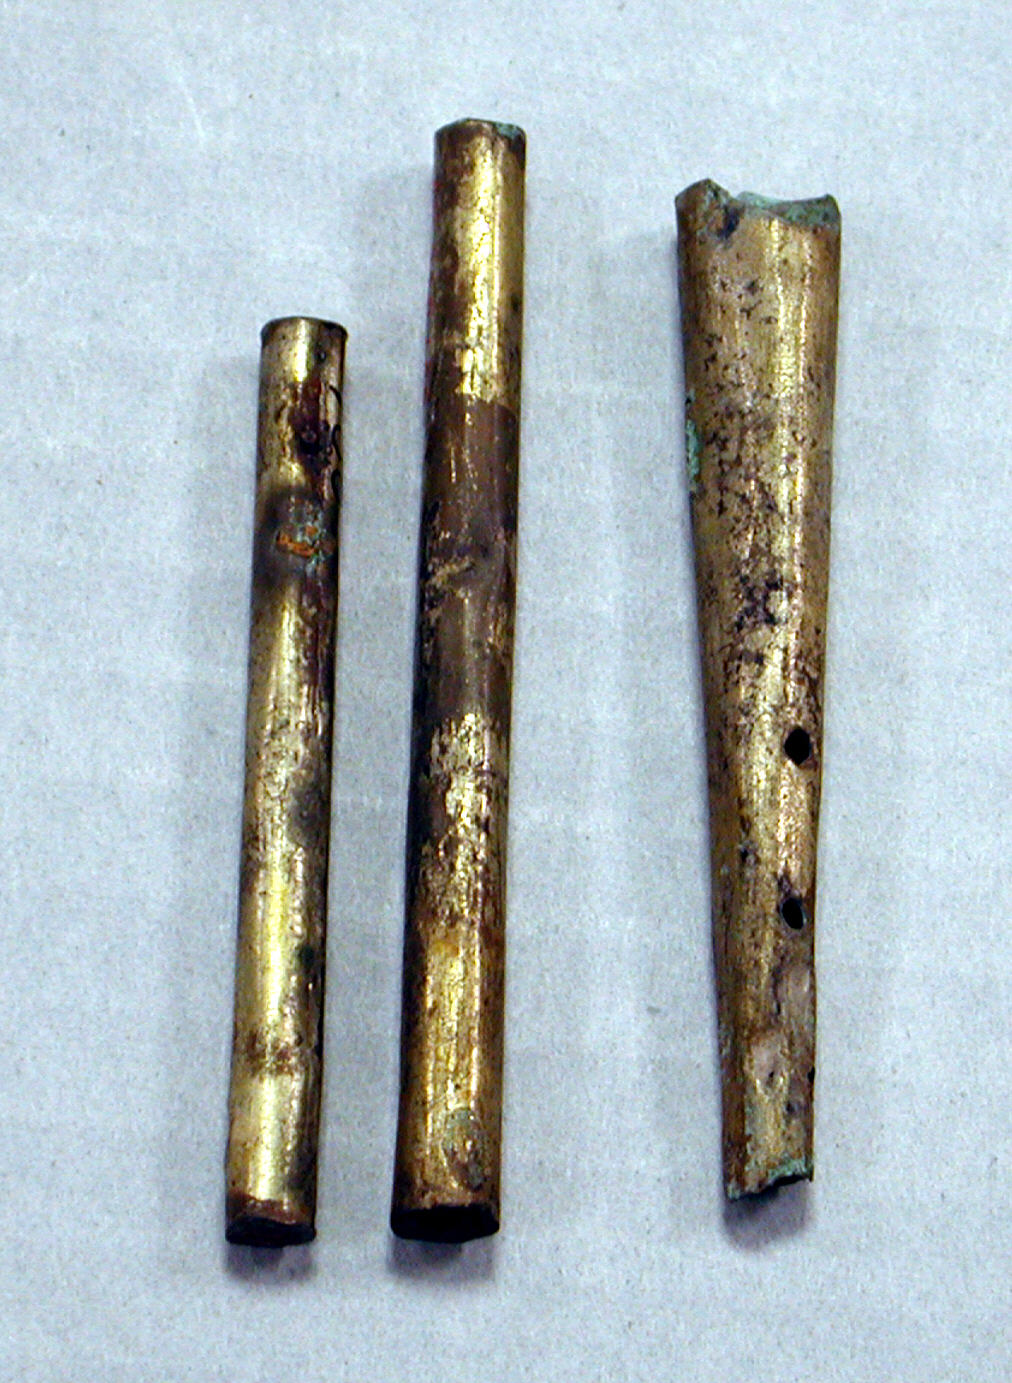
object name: ornament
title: Hammered Silver Tube Ornament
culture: peruvian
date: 701-1566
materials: gilt, silver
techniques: hammering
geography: peru